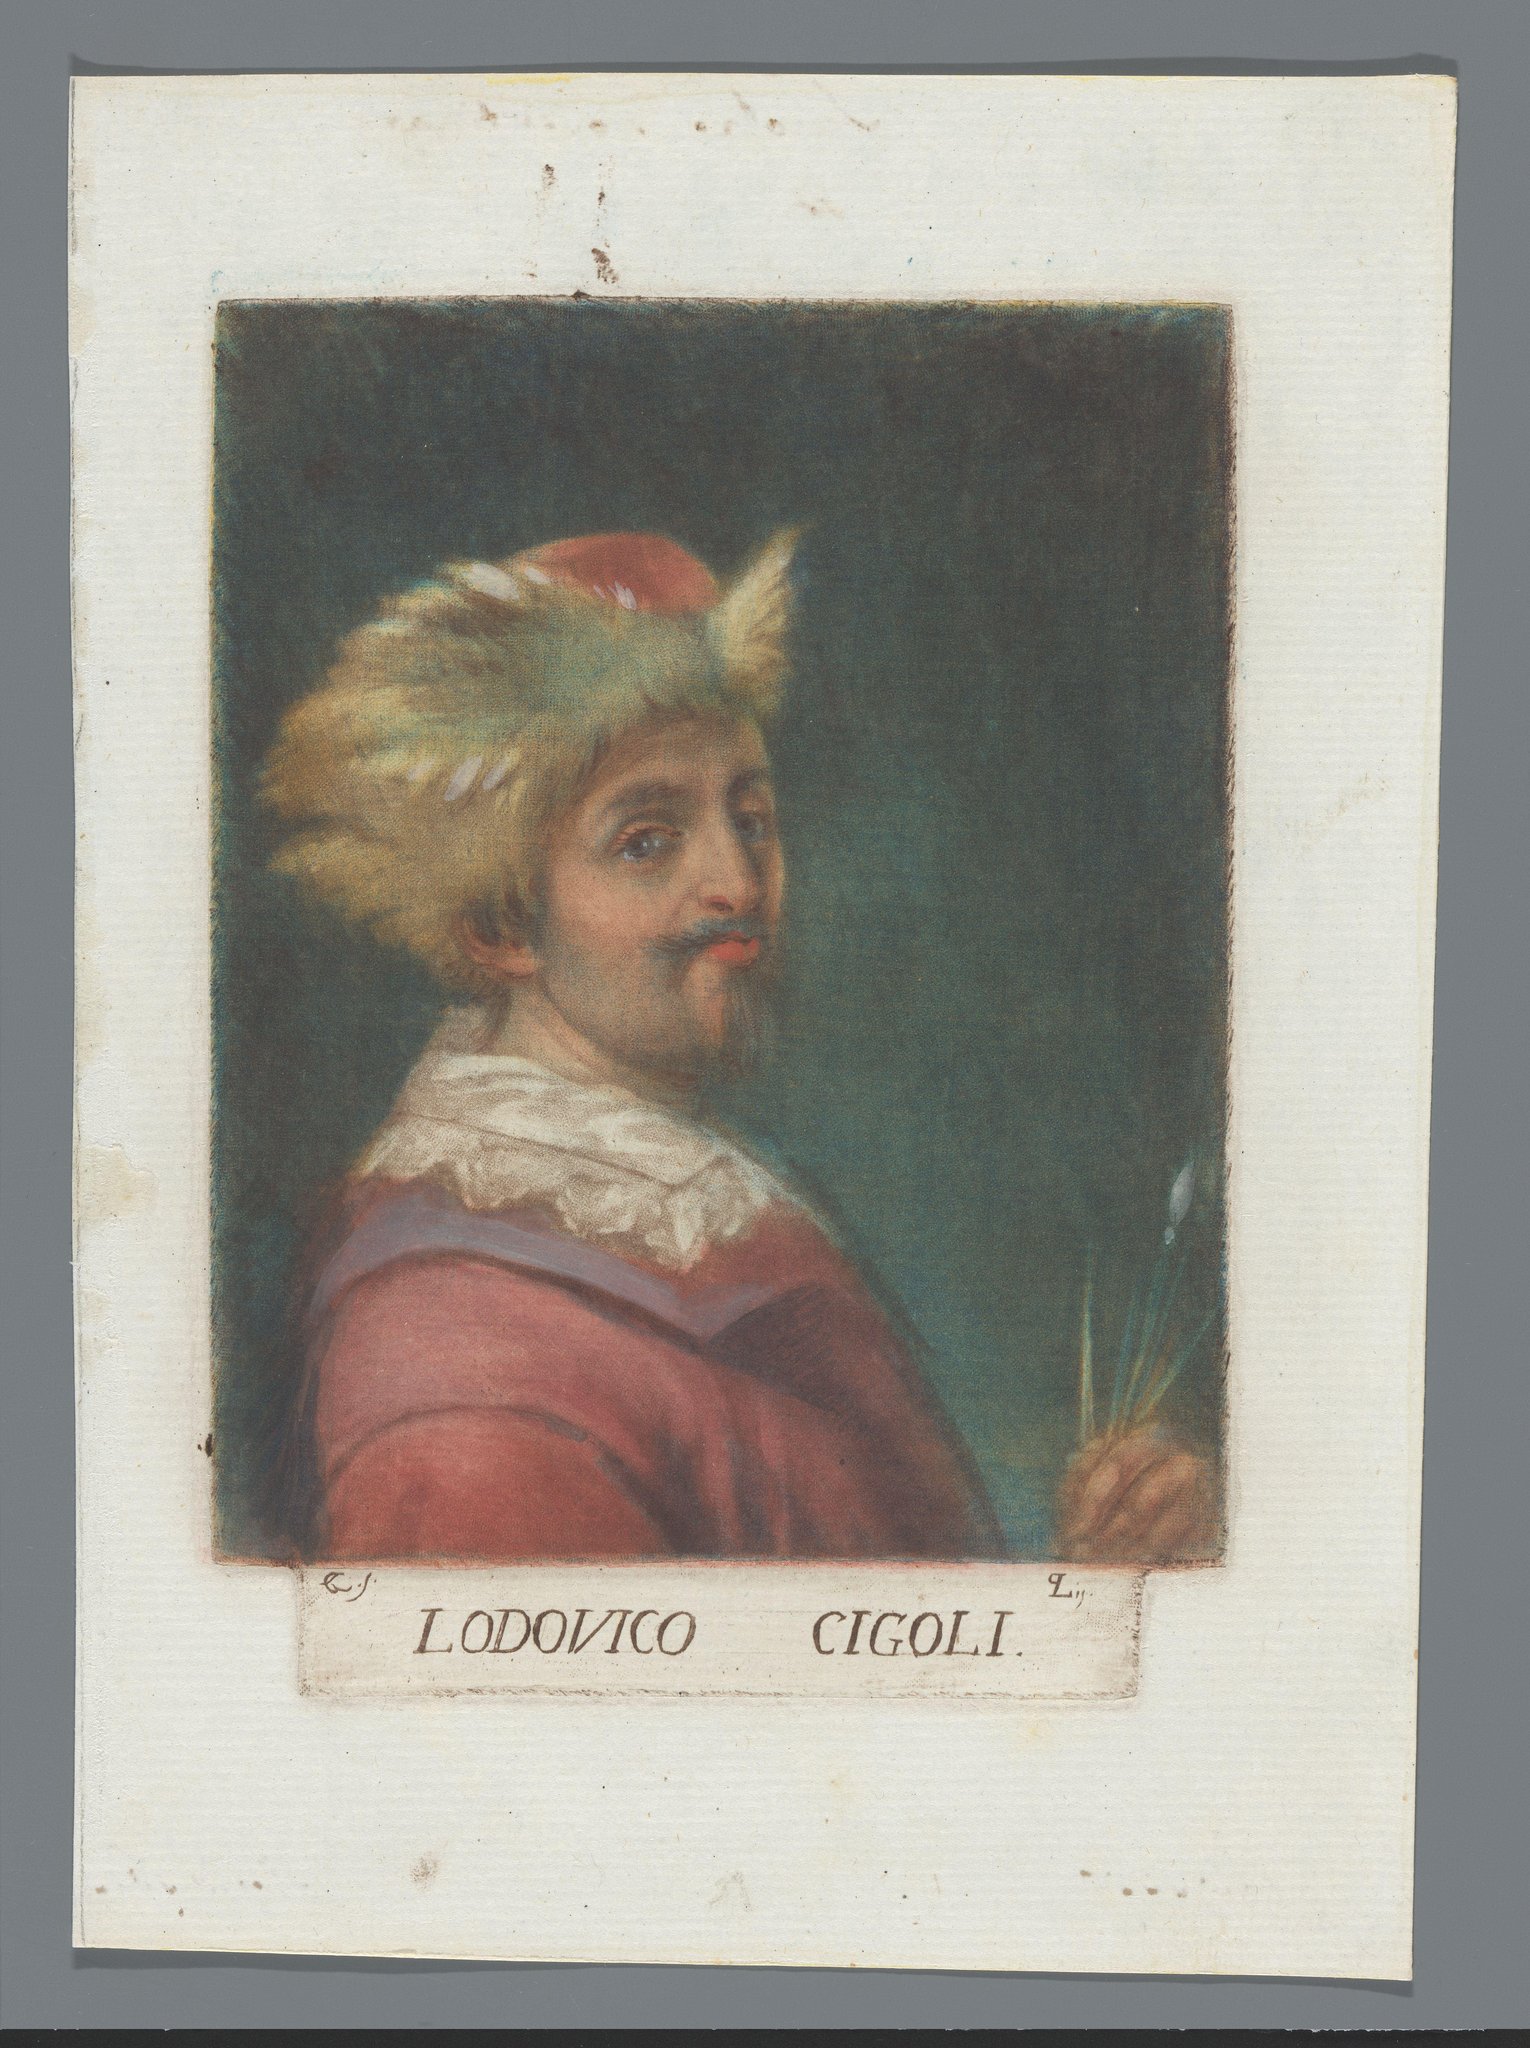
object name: print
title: Gli Autoritratti della Real Galleria di Firenze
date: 1789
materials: gouache, paper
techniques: color mezzotint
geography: florence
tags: rome, draughtsman, cigoli, historical persons, portrait, self-portrait of painter, portrait, self-portrait of artist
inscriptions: number: ‘23’, collector's mark: Lugt 2228, inscription:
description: Een prent uit een groep van veertig kleurendrukken met kunstenaarsportretten, gebaseerd op de collectie geschilderde zelfportretten van kunstenaars verzameld door de Medici in Florence. De groep maakt deel uit van het grote werk van Lasinio ‘Gli Autoritratti della Real Galleria di Firenze’, uitgegeven in 1789 met omstreeks 350 kunstenaarsportretten. Van deze uitgave is tot nog toe is geen compleet exemplaar bekend. In de inspringende marges onderaan de prenten zijn de namen van de kunstenaars aangebracht en soms hun levensdata en de plaats van geboorte en sterven en een enkele maal de signatuur van Lasinio en dat van de drukker Labrelis. Getuige de bindgaatjes en lijmresten moeten de prenten ingebonden zijn geweest in een album. De meeste prenten zijn verso voorzien van nummers in potlood, met als laagste nummer 2 en hoogste 93. Tevens zijn er verso Italiaanse opschriften in pen aangebracht met de levensdata van de kunstenaars en de school waartoe zij worden gerekend. Deze opschriften zijn vrijwel alle deels afgesneden. Elf prenten zijn niet genummerd en niet voorzien van opschriften. Deze laatste elf zijn alle gedrukt op blauw papier.